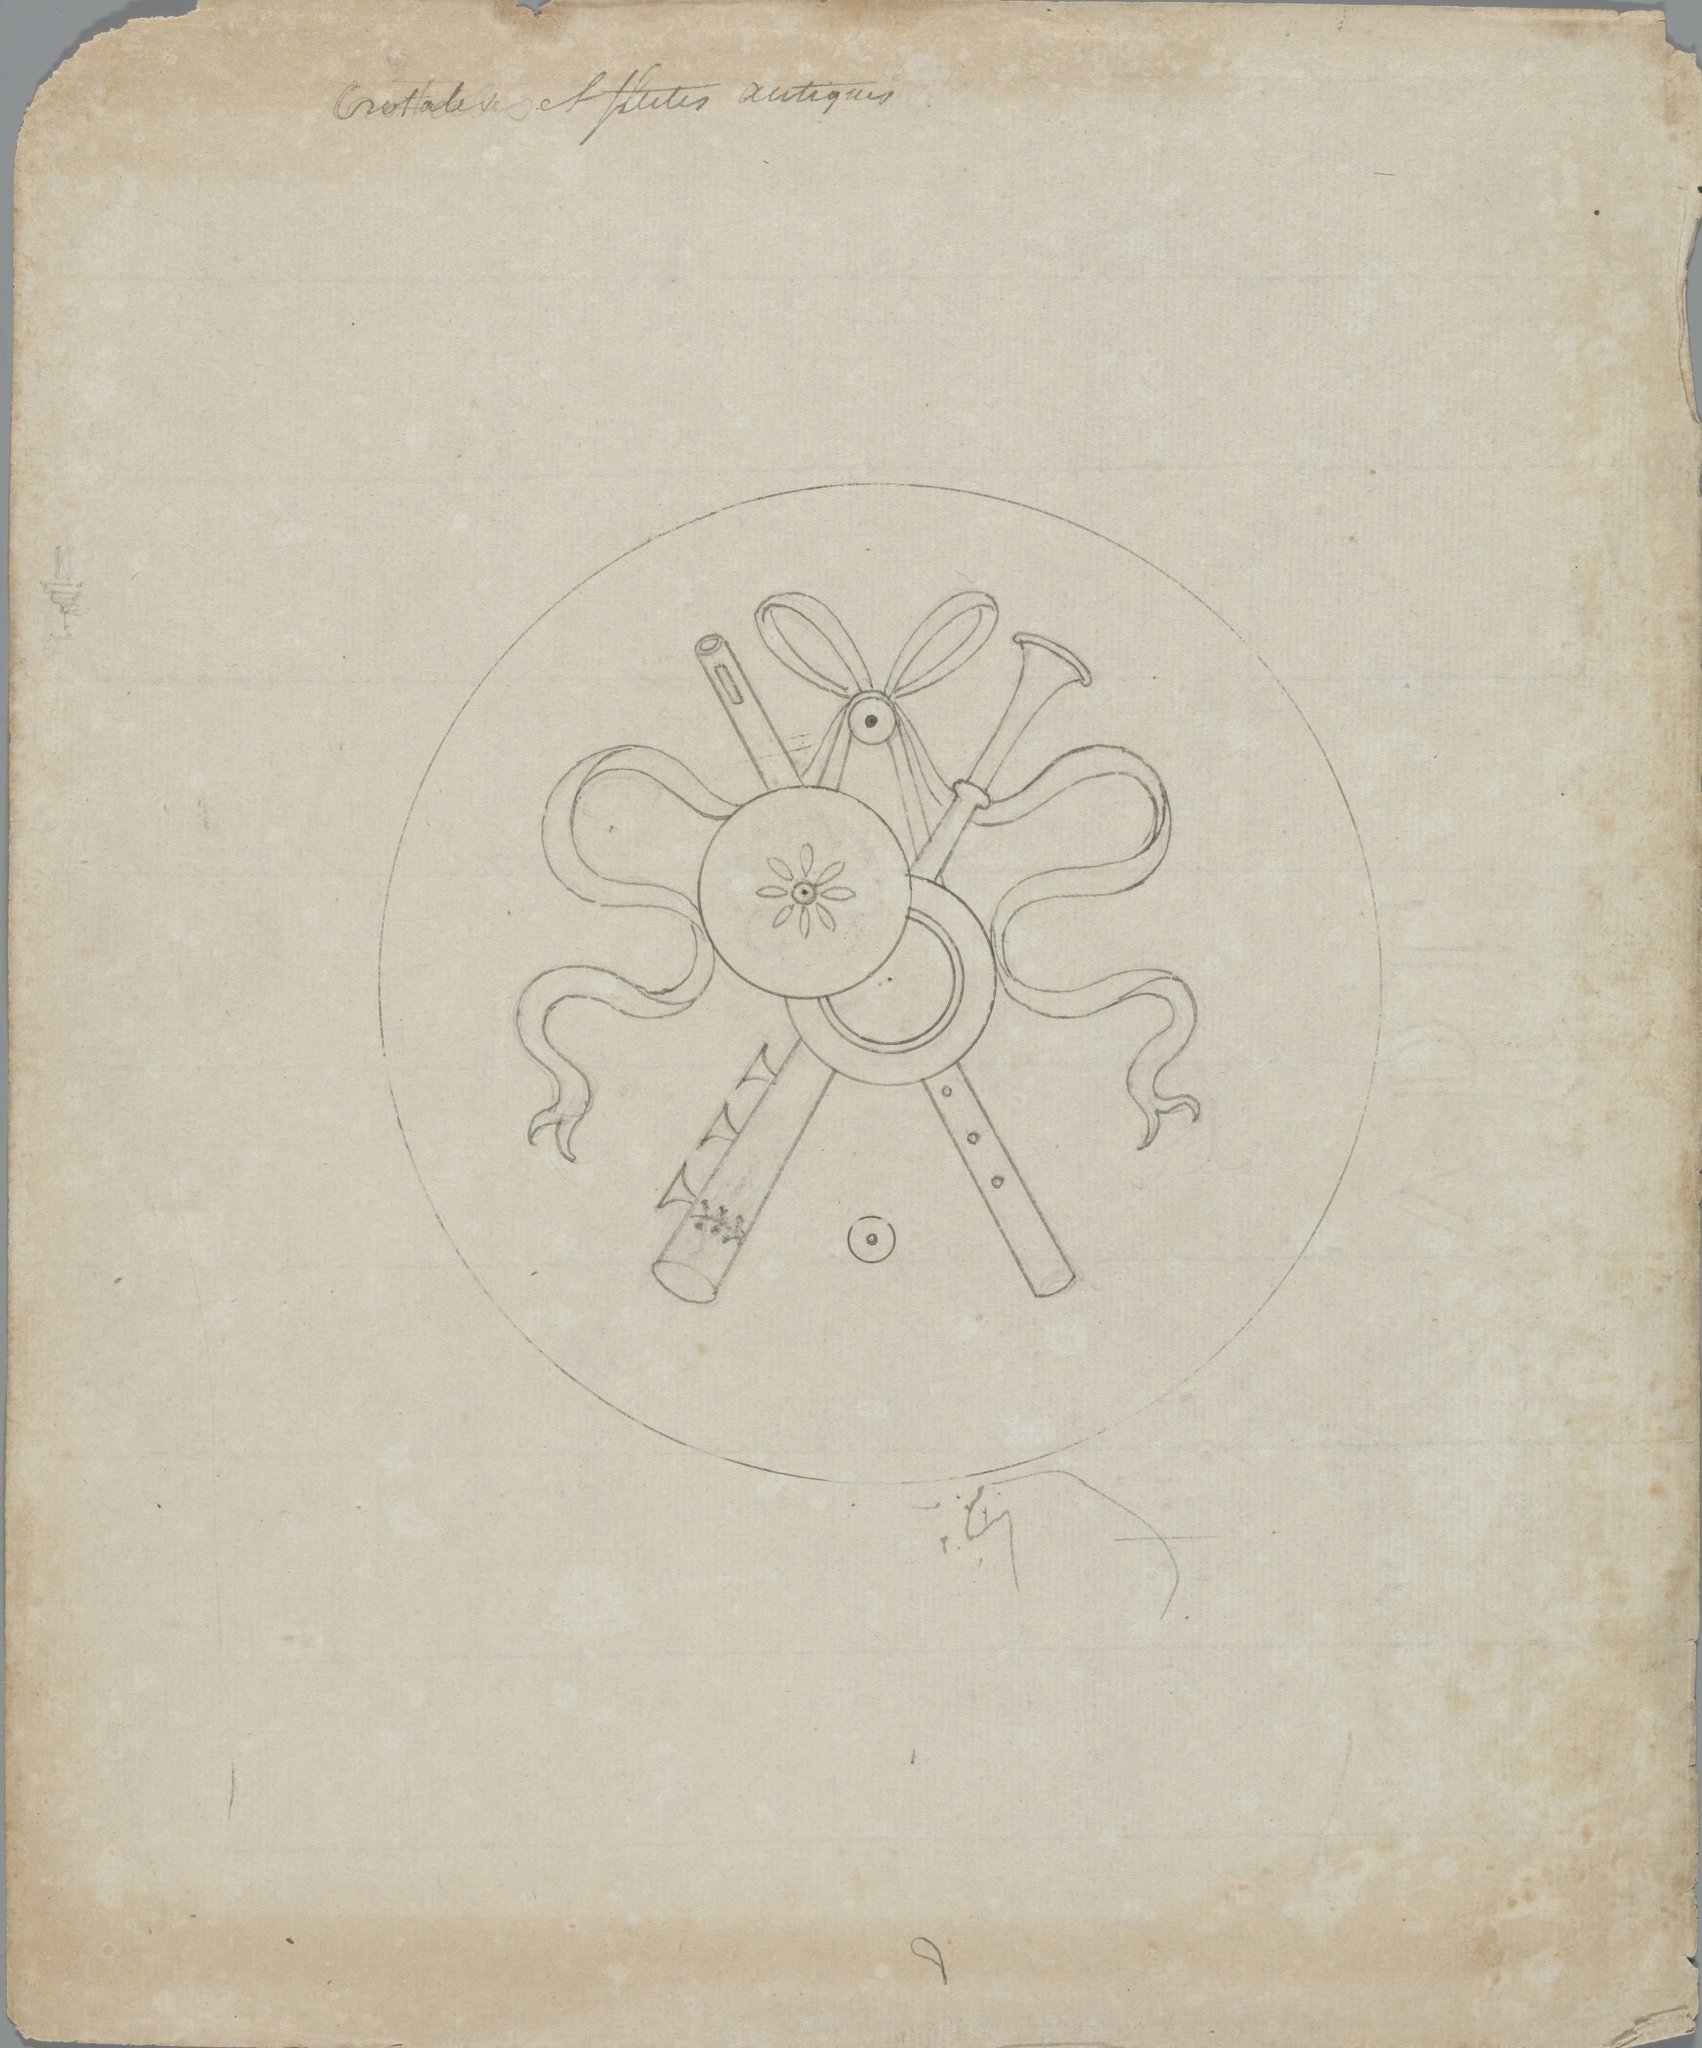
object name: design drawing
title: Crotale et flutes antiques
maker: pierre félix van doren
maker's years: 1797-1856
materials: graphite, ink, paper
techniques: pen in black ink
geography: brussels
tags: trophy, i.e.: decorative arrangement of symbolic or typical objects ~ ornament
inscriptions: inscription: ‘Crotale et flutes antiques’, watermark: ‘VDL’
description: Een van 103 ontwerpen voor marqueterie van aan linten opgehangen muziekinstrumenten in ronde medaillons, bestemd voor de set stoelen gemaakt door Van Doren voor de grote zaal van het Paleis van de Prins van Oranje in Brussel in 1828.